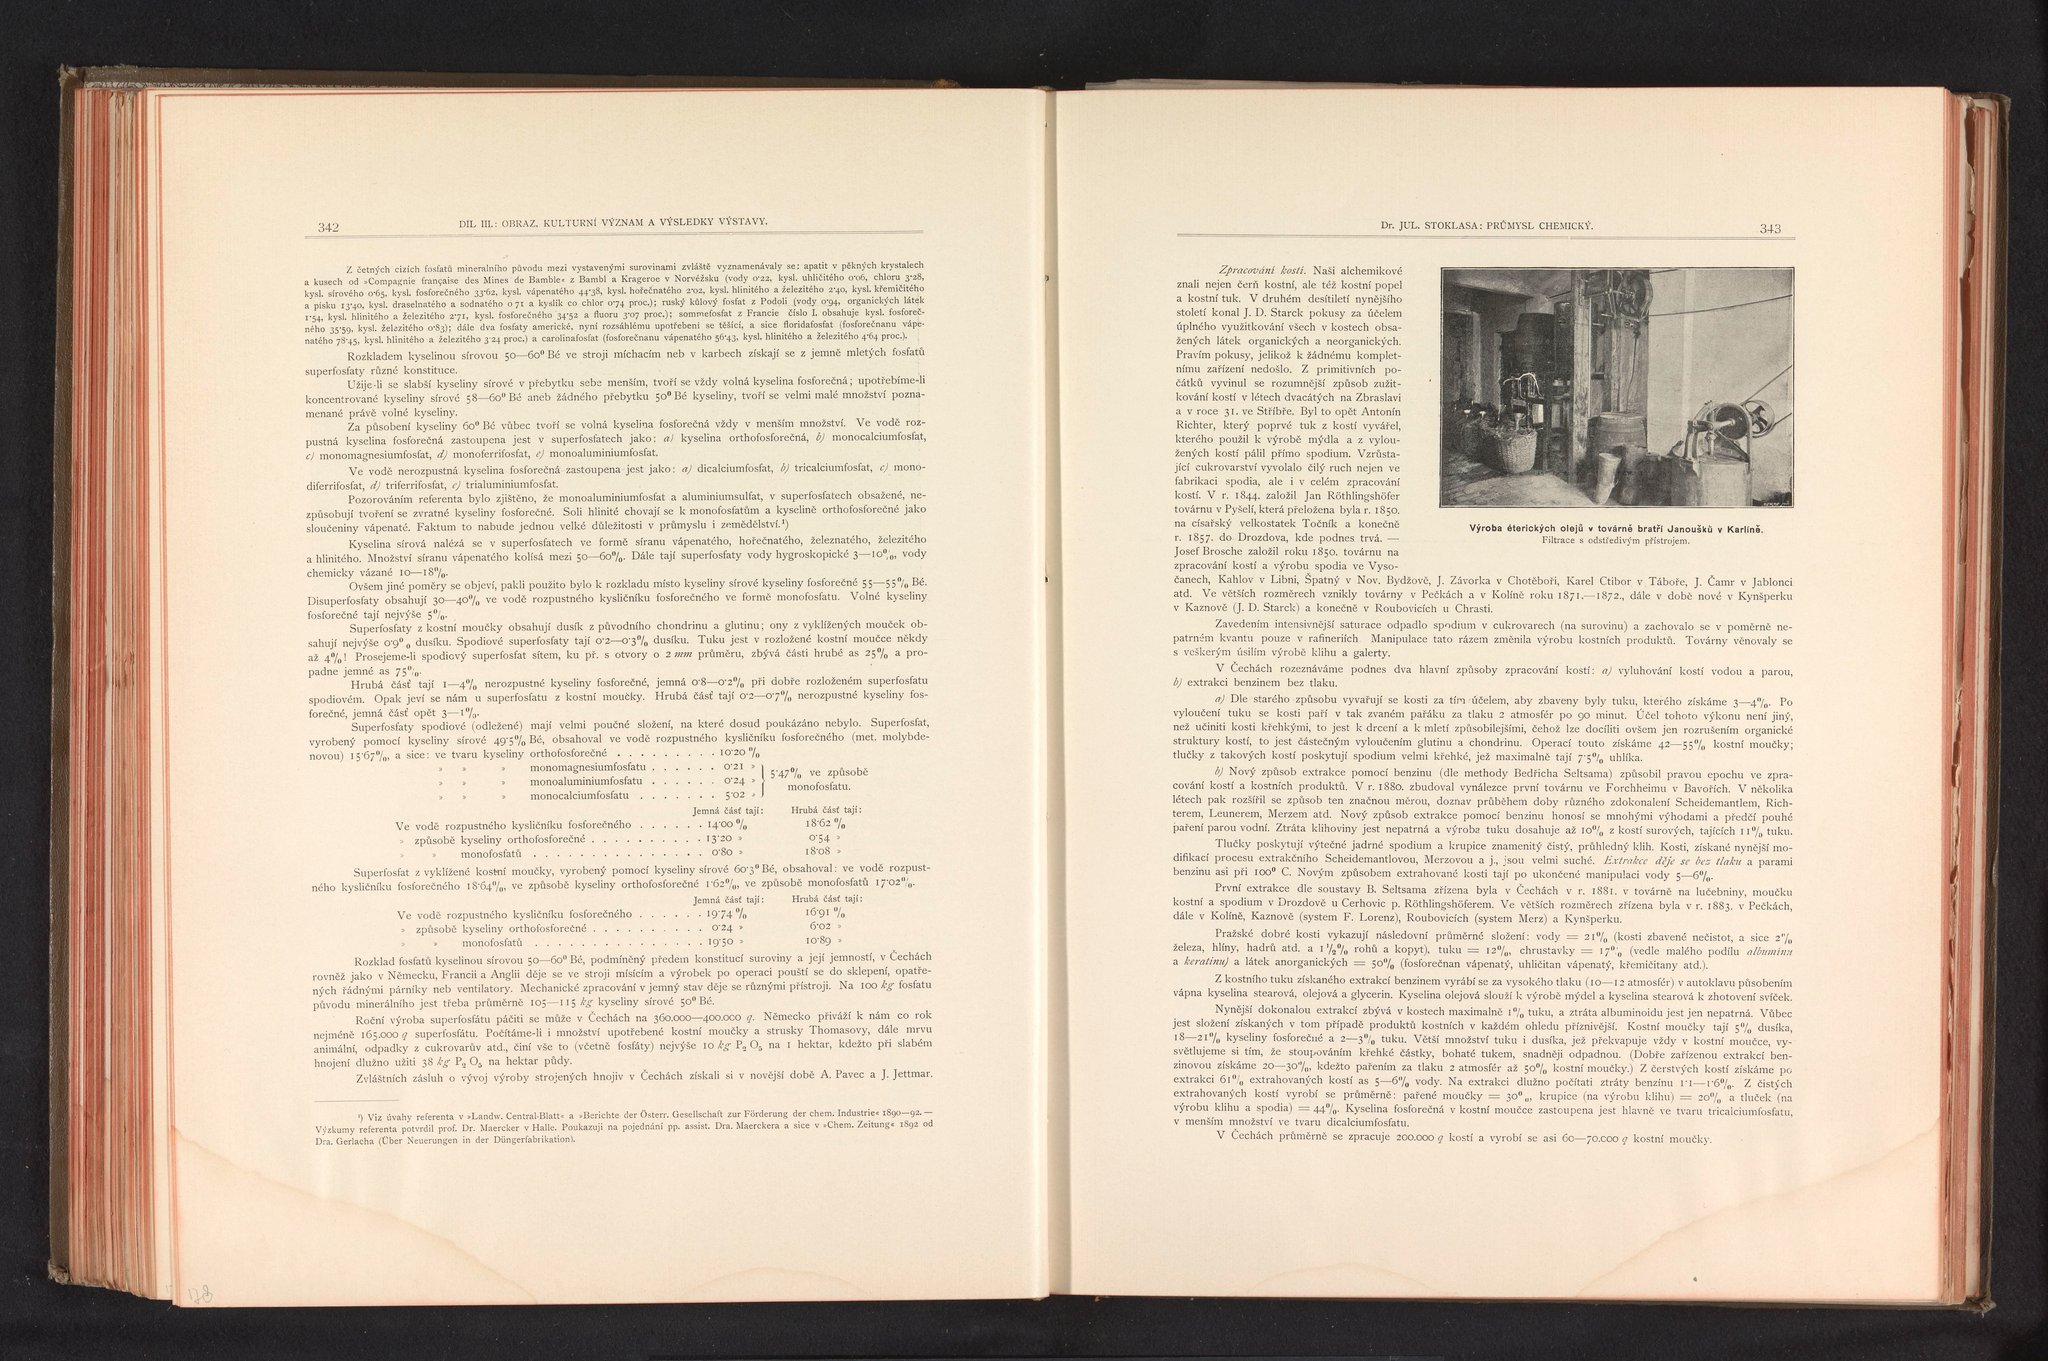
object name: page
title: Výroba éterických oleju v továrna bratri Janousku v Karline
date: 1890-1895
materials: paper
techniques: autotype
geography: prague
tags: chandelier, candelabrum